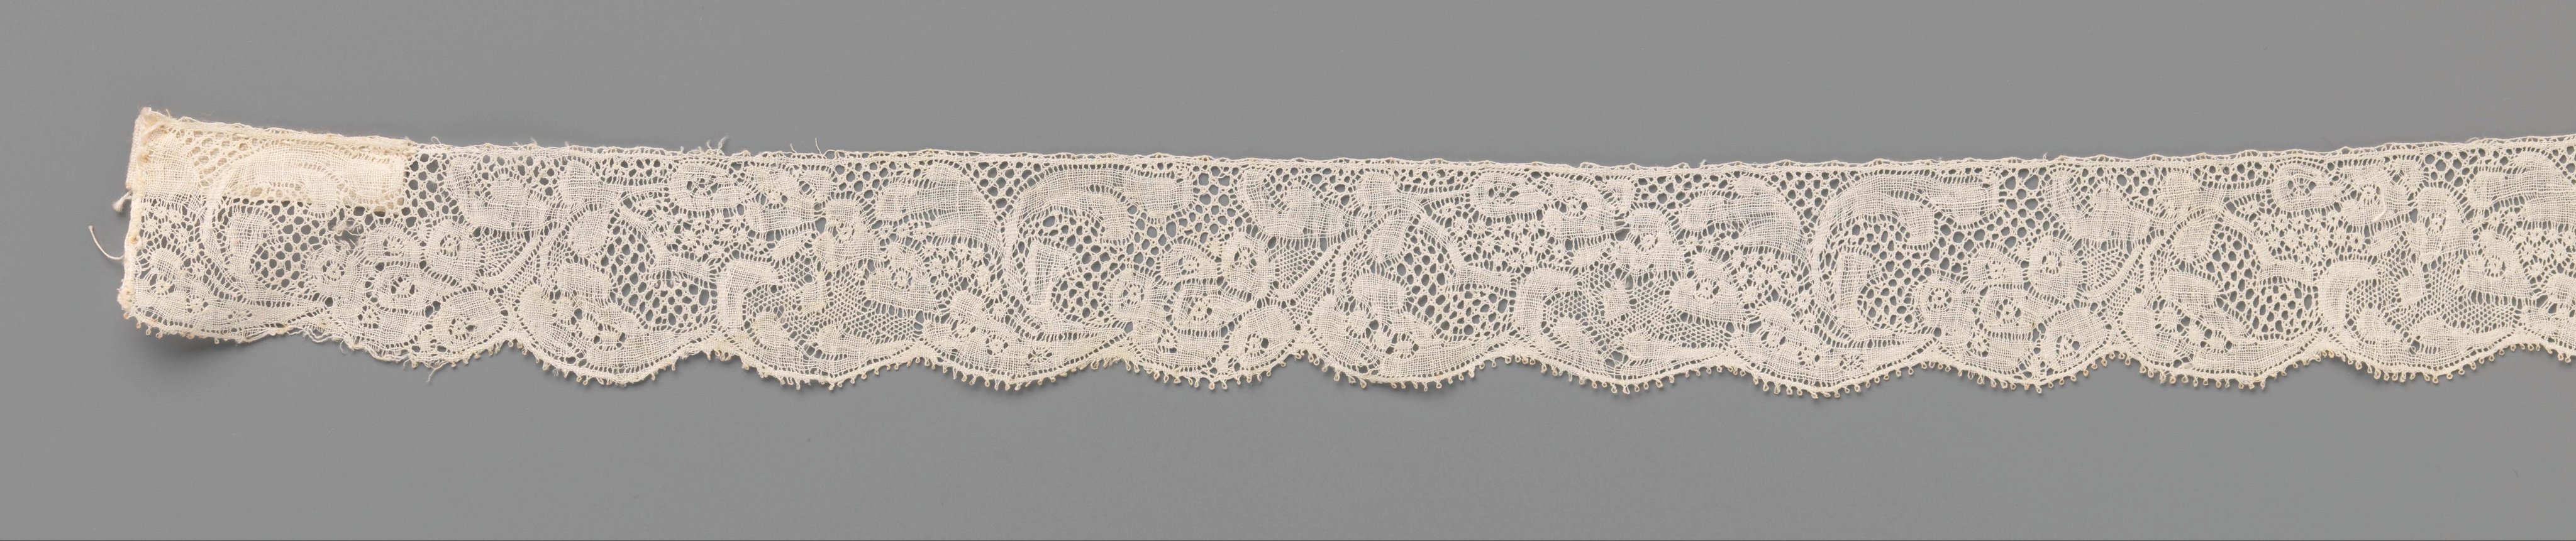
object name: strip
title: Strook kloskant met hartvormige blaadjes die overlopen in een bloemstengel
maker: Anonymous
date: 1740-1760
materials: linen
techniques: lace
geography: southern netherlands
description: Strook naturekleurige kloskant, Binche-kant. Het zich herhalende en doorlopende patroon bestaat uit een golf gevormd door hartvormige blaadjes, die overlopen in een bloemstengel met aan het uiteinde een vijflobbige bloem met een druppelvormig hart. De motieven zijn met elkaar verbonden door een traliegrond, een vijfgaatjesgrond. De motieven zijn gemaakt in linnenslag met opengewerkte randjes en netslagvullingen. Verschillende tussenruimten zijn gevuld met een siergrond, een sneeuwvlokkengrond. Ook zijn één of enkele sneeuwvlokken gebruikt in de blaadjes, bloemblaadjes en hartjes. De schulpen langs de onderzijde komen voort uit het patroon en zijn afgewerkt met picots. De bovenzijde is recht afgewerkt.